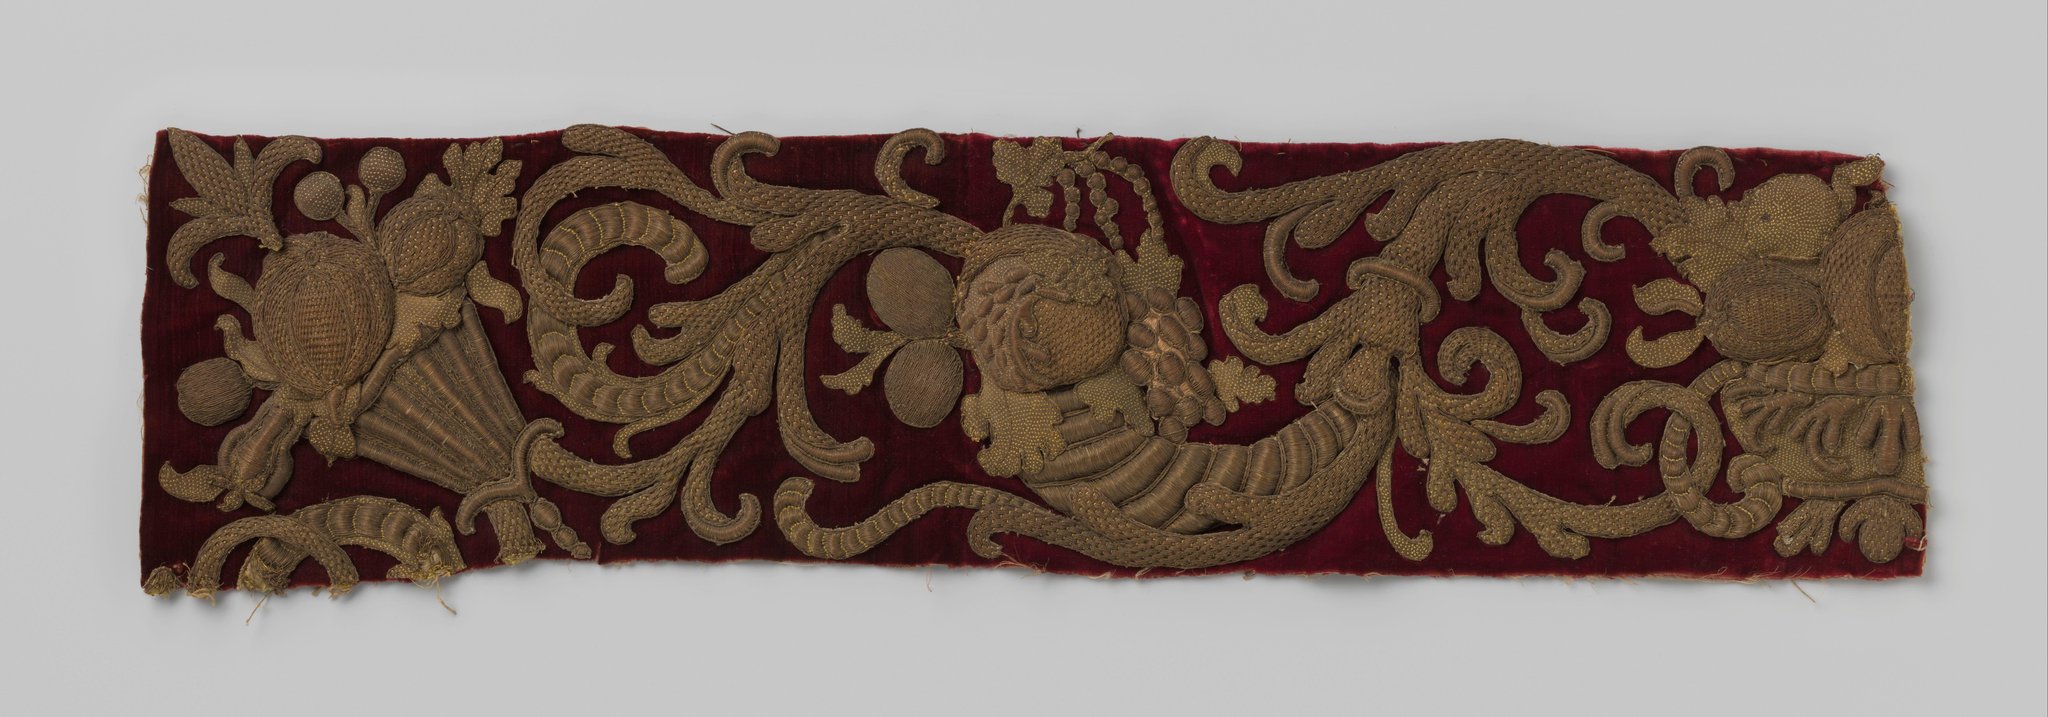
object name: strip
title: Strook borduurwerk.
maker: Anonymous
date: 1700-1725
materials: gold thread, velvet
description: Strook met gouden borduurwerk op karmozijnrode, fluwelen grond.